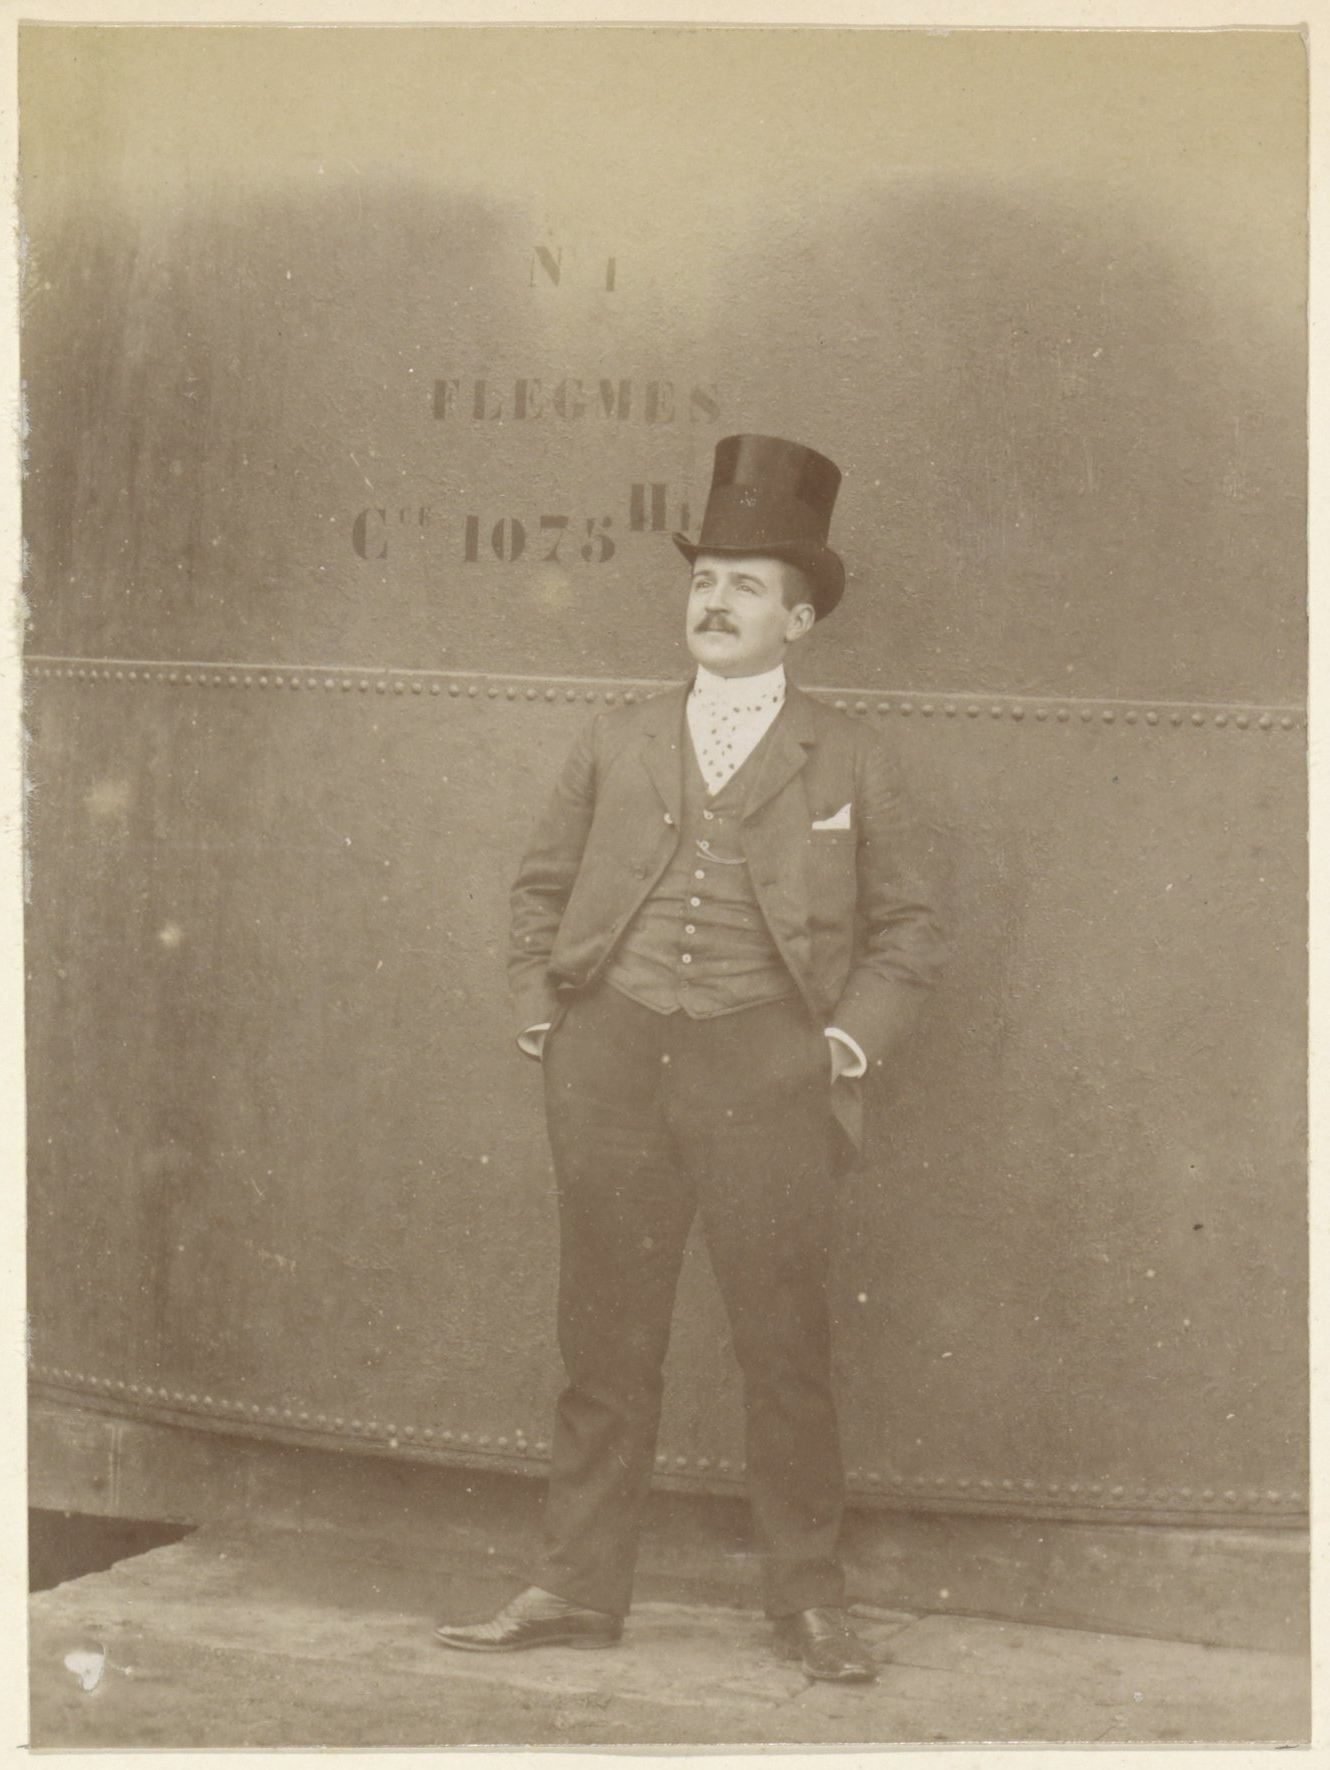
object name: photograph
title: Portret van een Franse man met een hoge hoed, staand voor een metalen vat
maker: Anonymous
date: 1900-1910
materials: paper, photographic support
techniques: albumen print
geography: france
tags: hand in the pocket - aa - both arms or hands, adult man, container of metal: bucket, can, canister, drum, tin, head-gear: top hat, france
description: Onderdeel van Fotoalbum van een Franse amateurfotograaf met opnames van een familie, distilleerderij Delizy & Doistau Fils, het leger en bezienswaardigheden in Frankrijk.